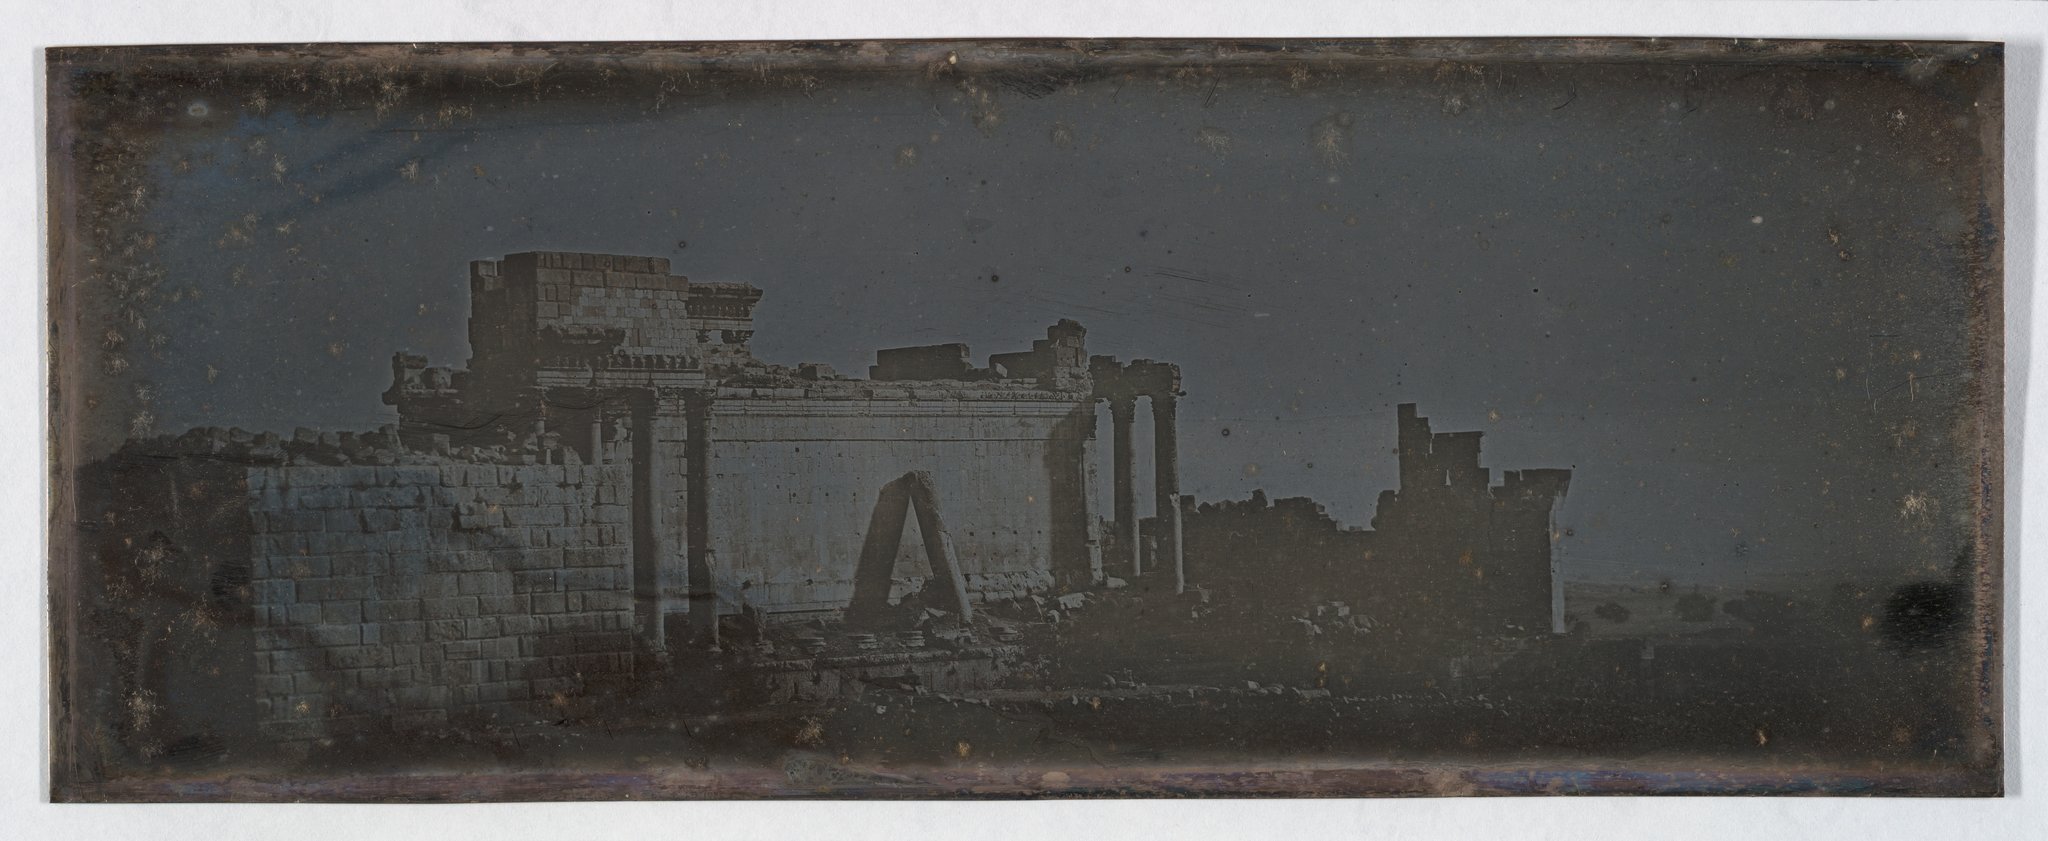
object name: photograph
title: Baalbek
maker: joseph-philibert girault de prangey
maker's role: artist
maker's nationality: french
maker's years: 1804-1892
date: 1843-1844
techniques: daguerreotype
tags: architecture,ruins